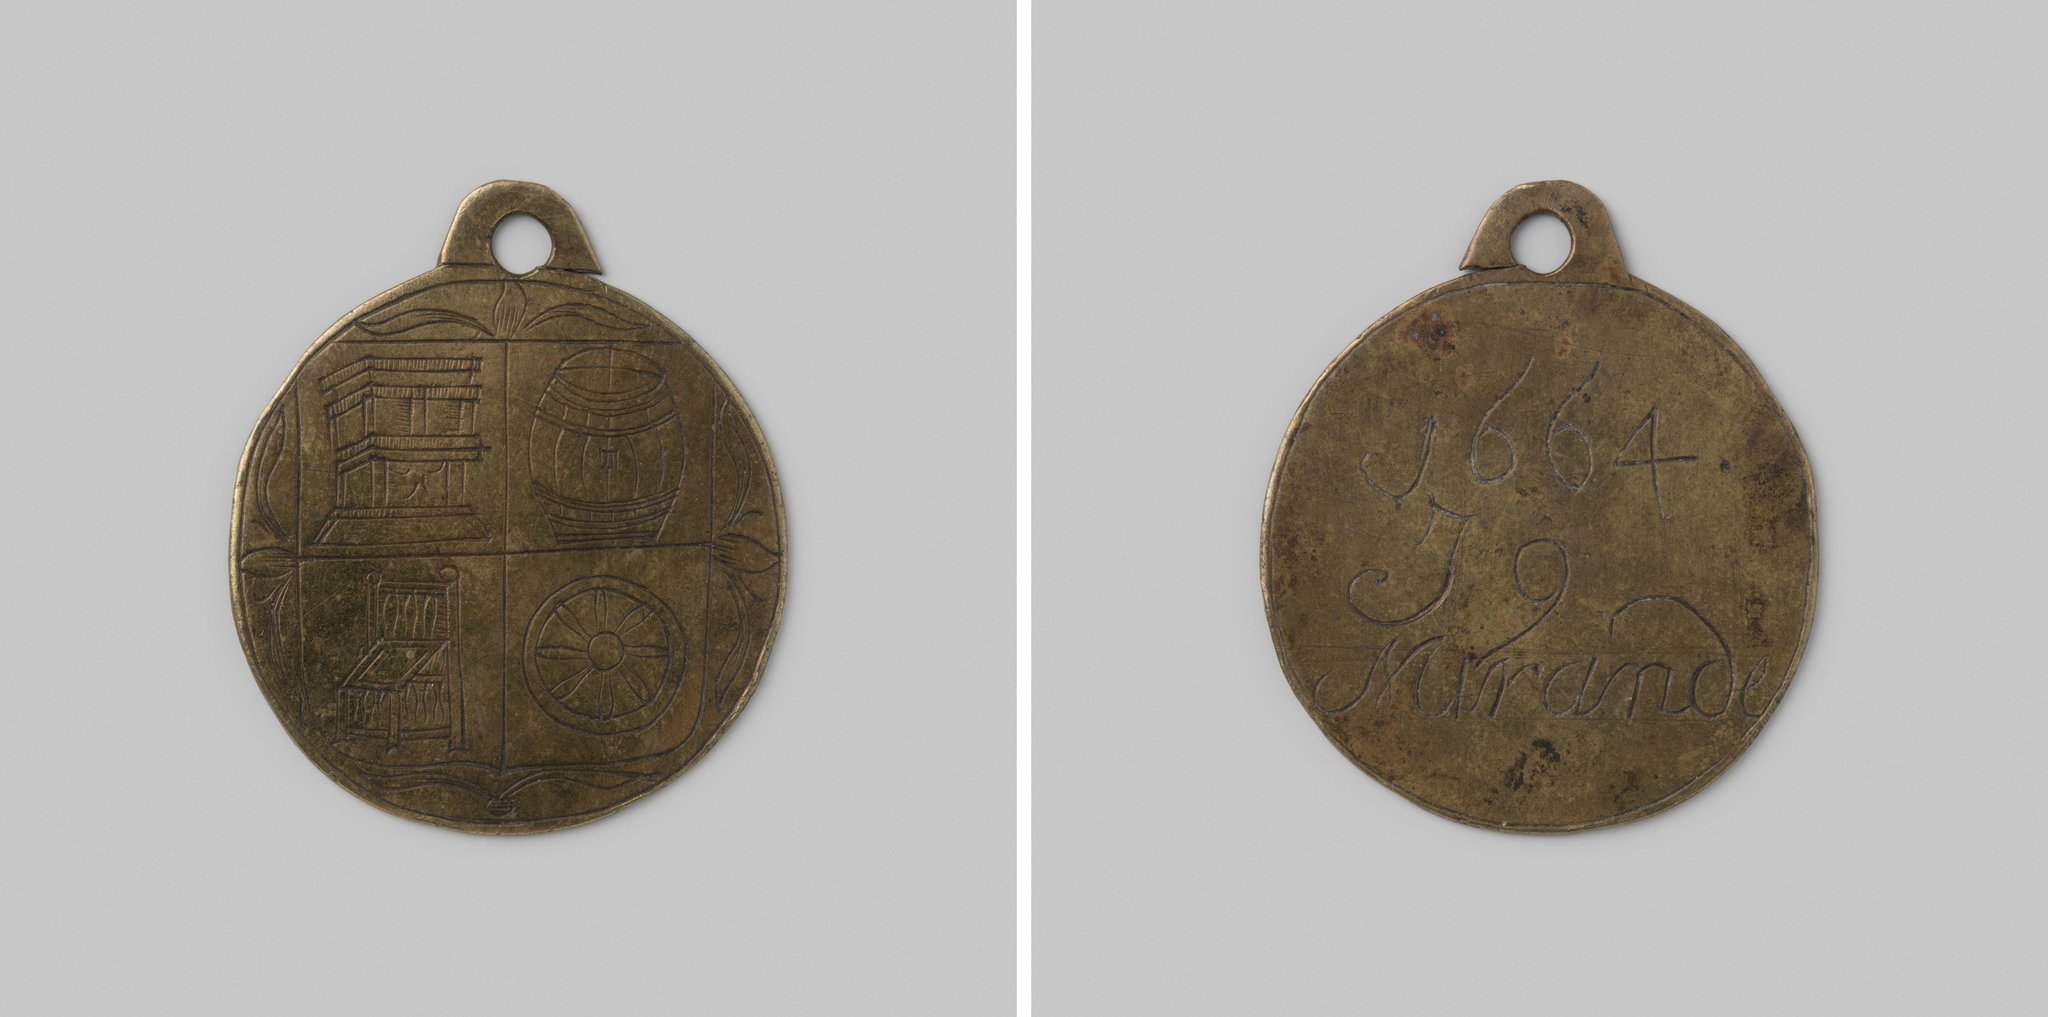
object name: history medal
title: Presentiepenning van het Rademakers-, Kuipers-, Draaiers- en Schrtijnwerkersgilde te 's-Hertogenbosch 1664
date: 1664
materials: brass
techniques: engraving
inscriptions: inscription: ‘J.G. / Mirande’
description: Rond messing plaatje, gegraveerd op de voorzijde een wapenschild met kast, ton, stoel en wiel, op de keerzijde het jaartal 1664 en de naam J.G. Mirande, met draagoog